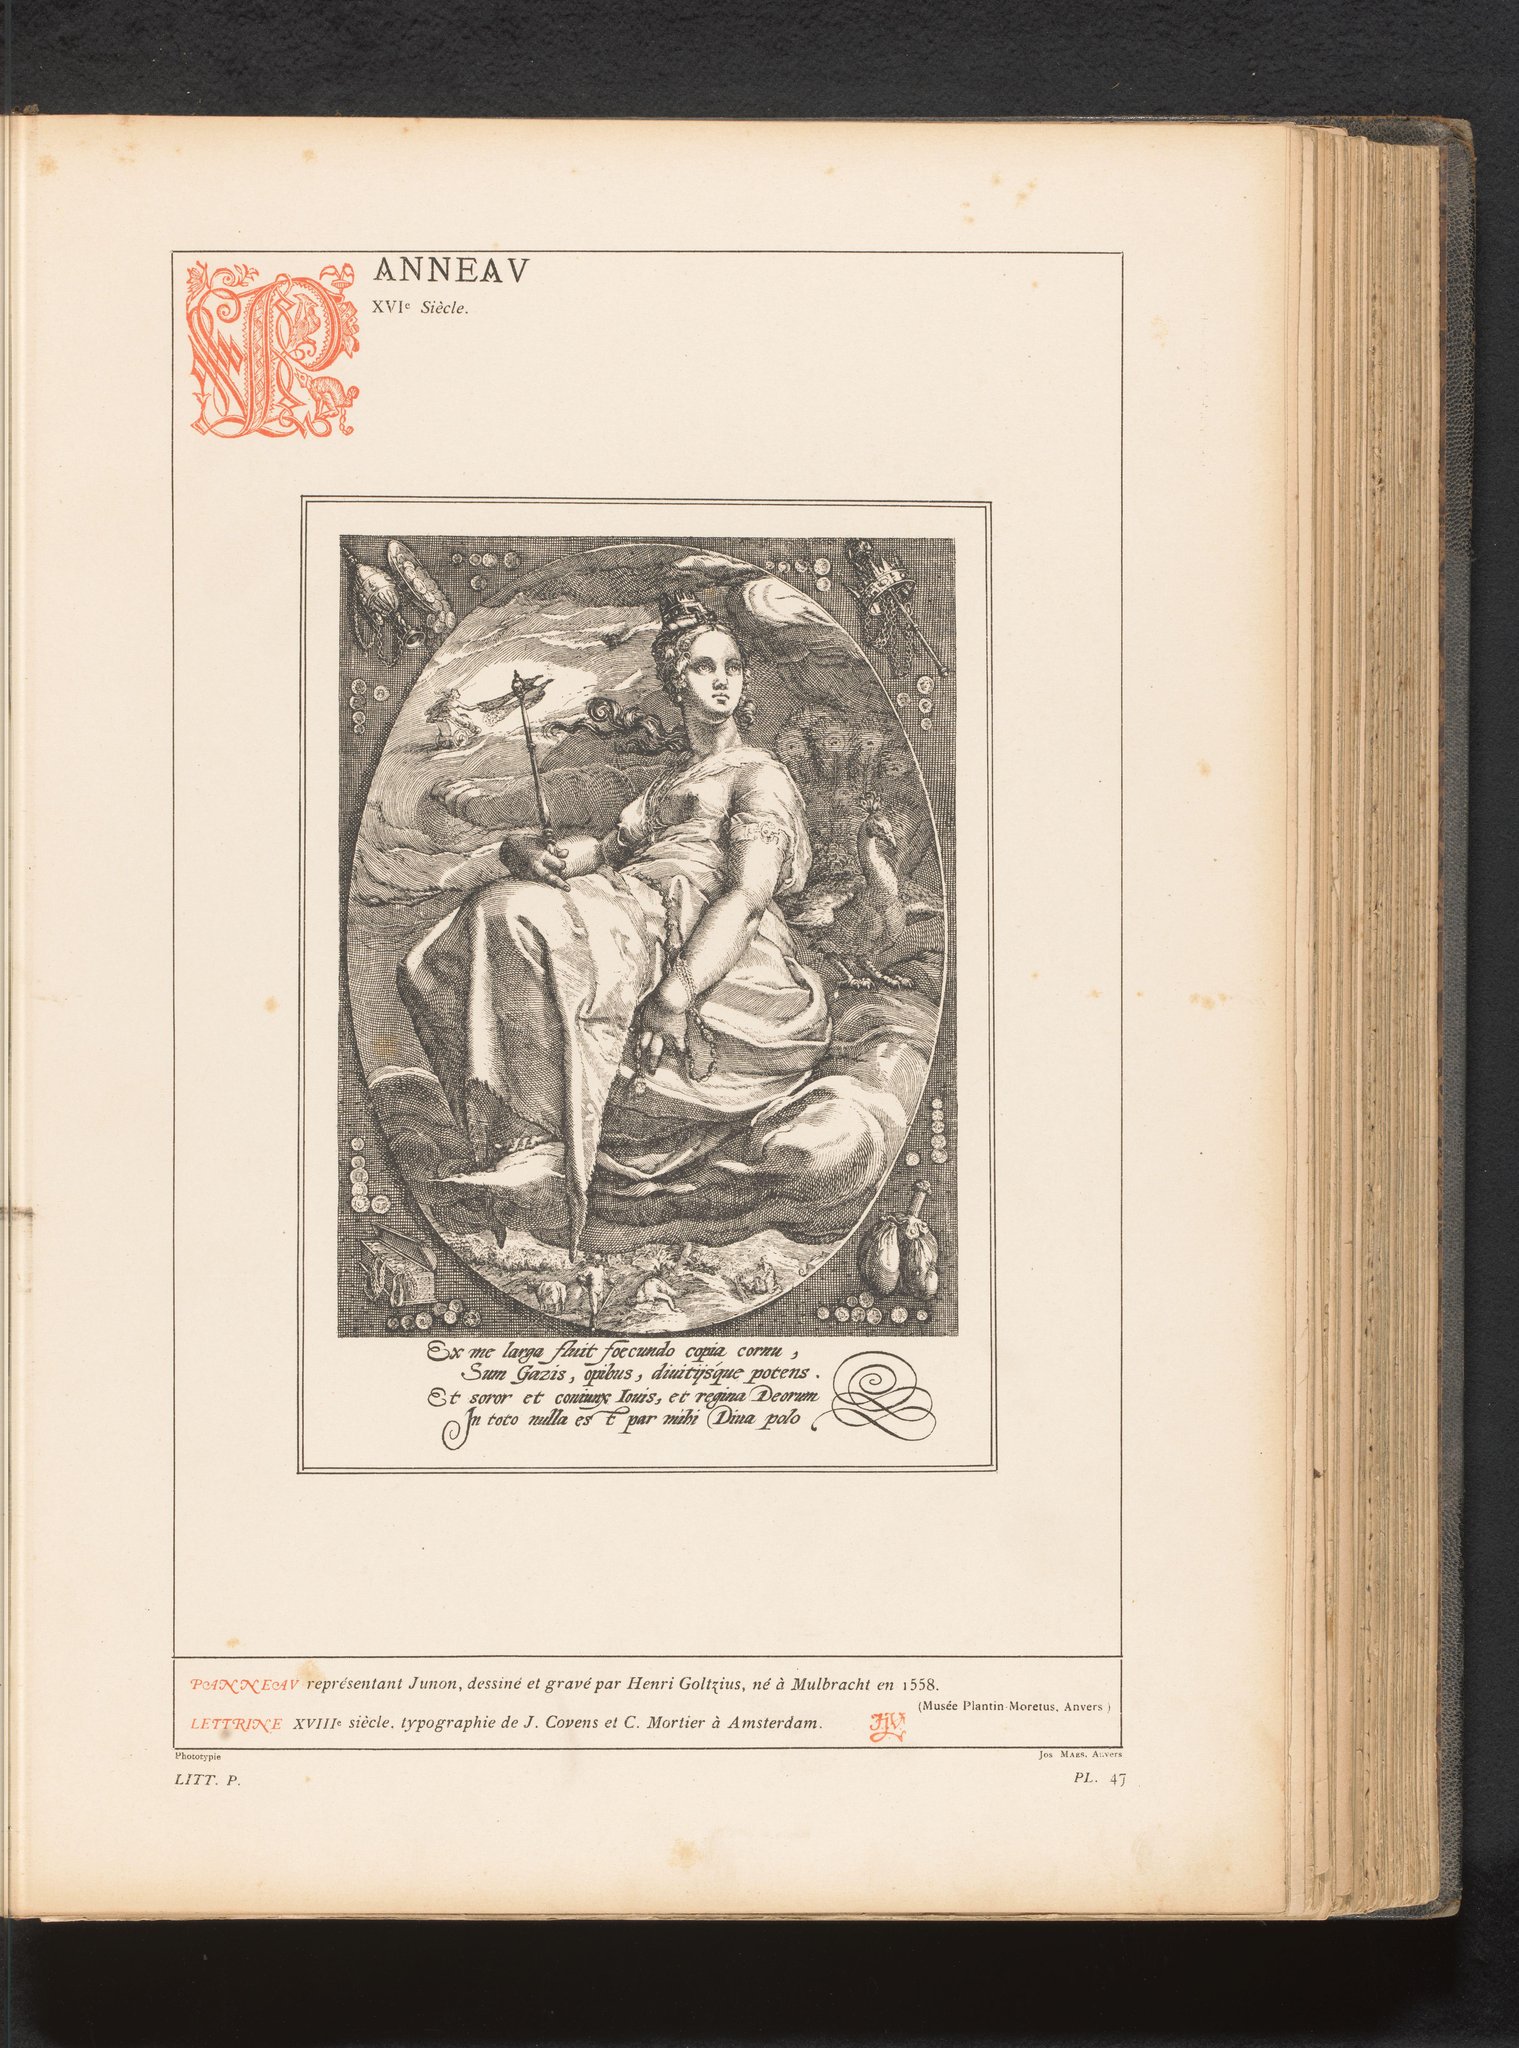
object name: reproduction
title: Reproductie van een prent van Juno door Hendrick Goltzius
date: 1876-1881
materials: paper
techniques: photolithography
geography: antwerp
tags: war of the titans against jupiter and allies: titanomachy, ornamental birds: peacock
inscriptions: inscription: ‘PANNEAU représentant Junon (...)’, inscription: ‘LITT. P. - PL. 47.’, monogram: ‘JJvY’